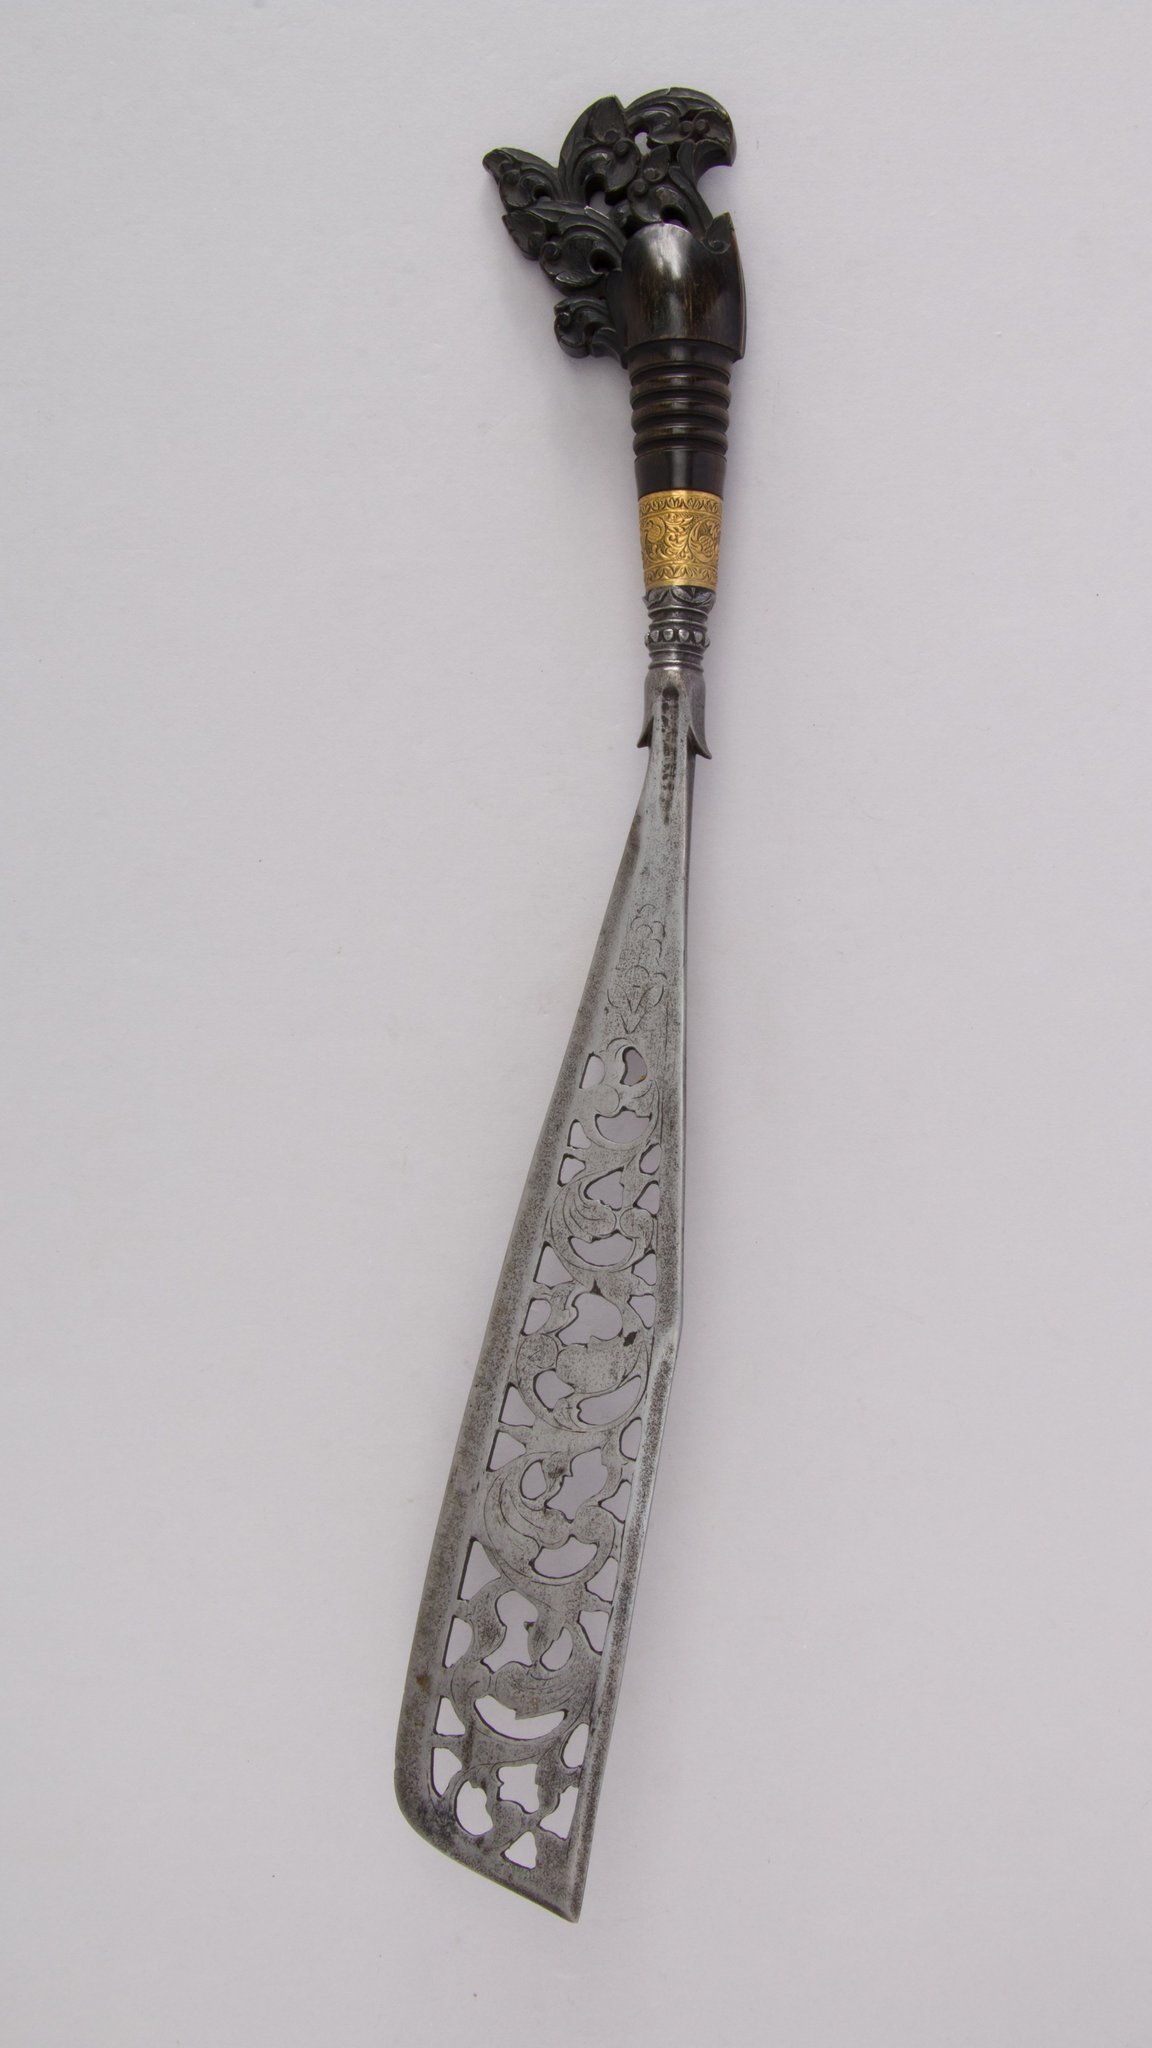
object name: knife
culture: javanese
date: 1501-1900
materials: gold, steel, wood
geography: indonesia